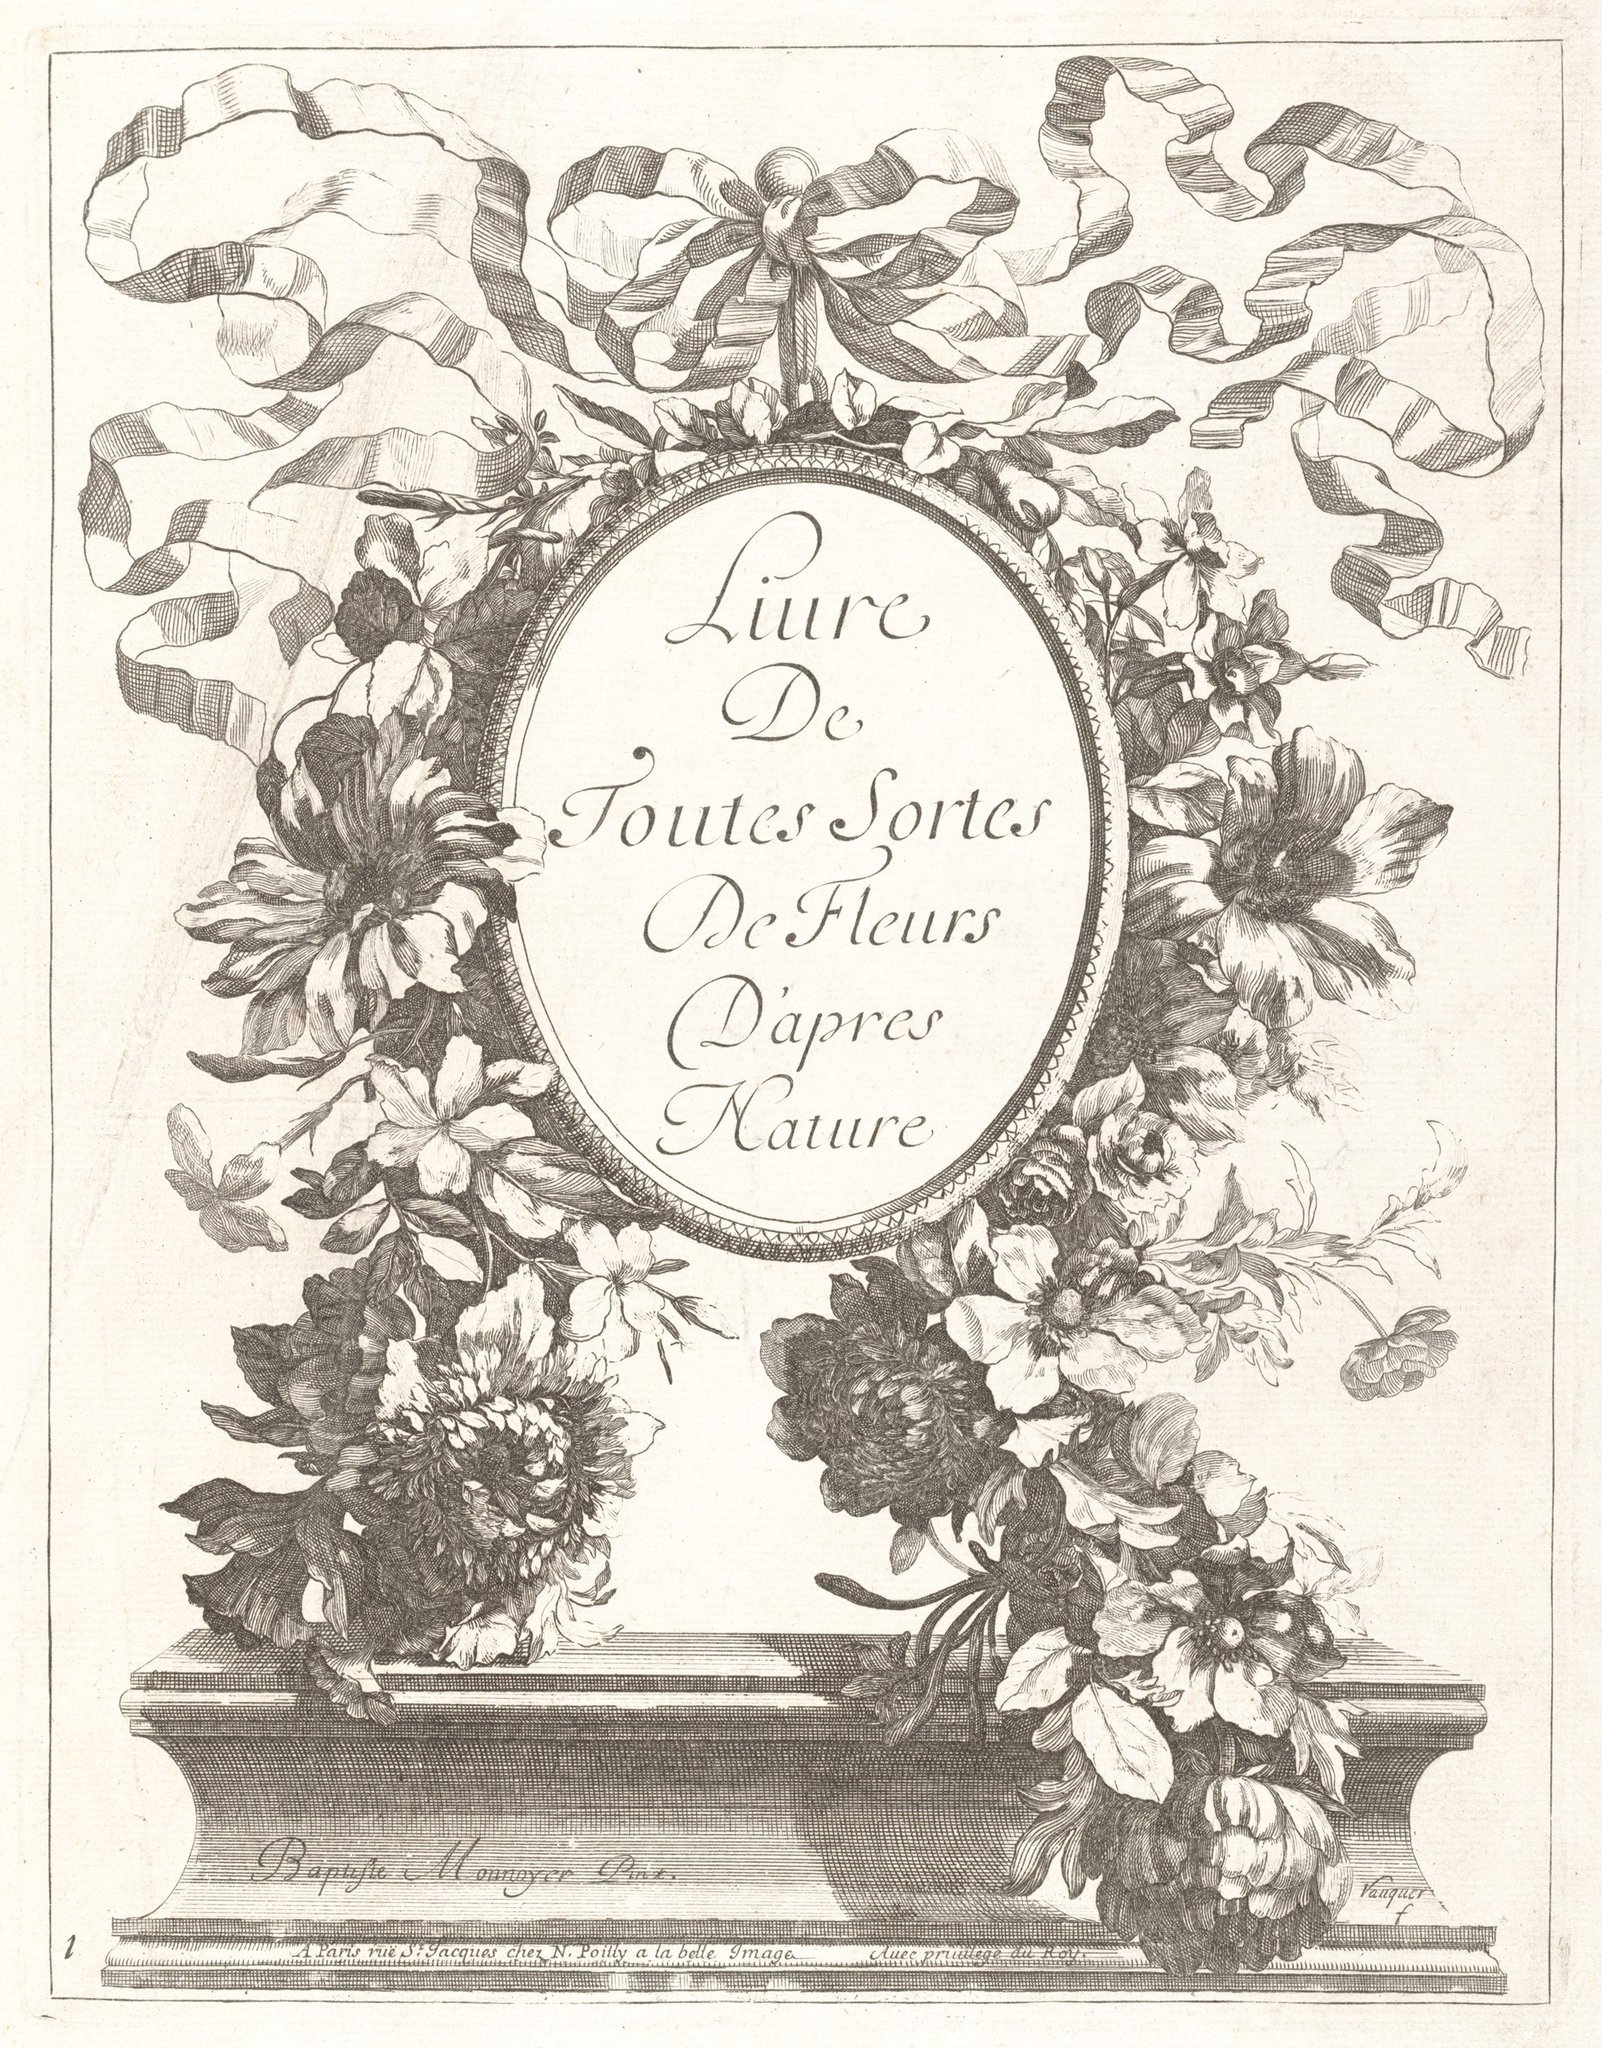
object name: book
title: Livre de Toutes Sortes De Fleurs D'apres Nature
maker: jean-baptiste monnoyer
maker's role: designer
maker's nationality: french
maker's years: 1636-1699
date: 1670-1680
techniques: engraving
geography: france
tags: flowers,leaves